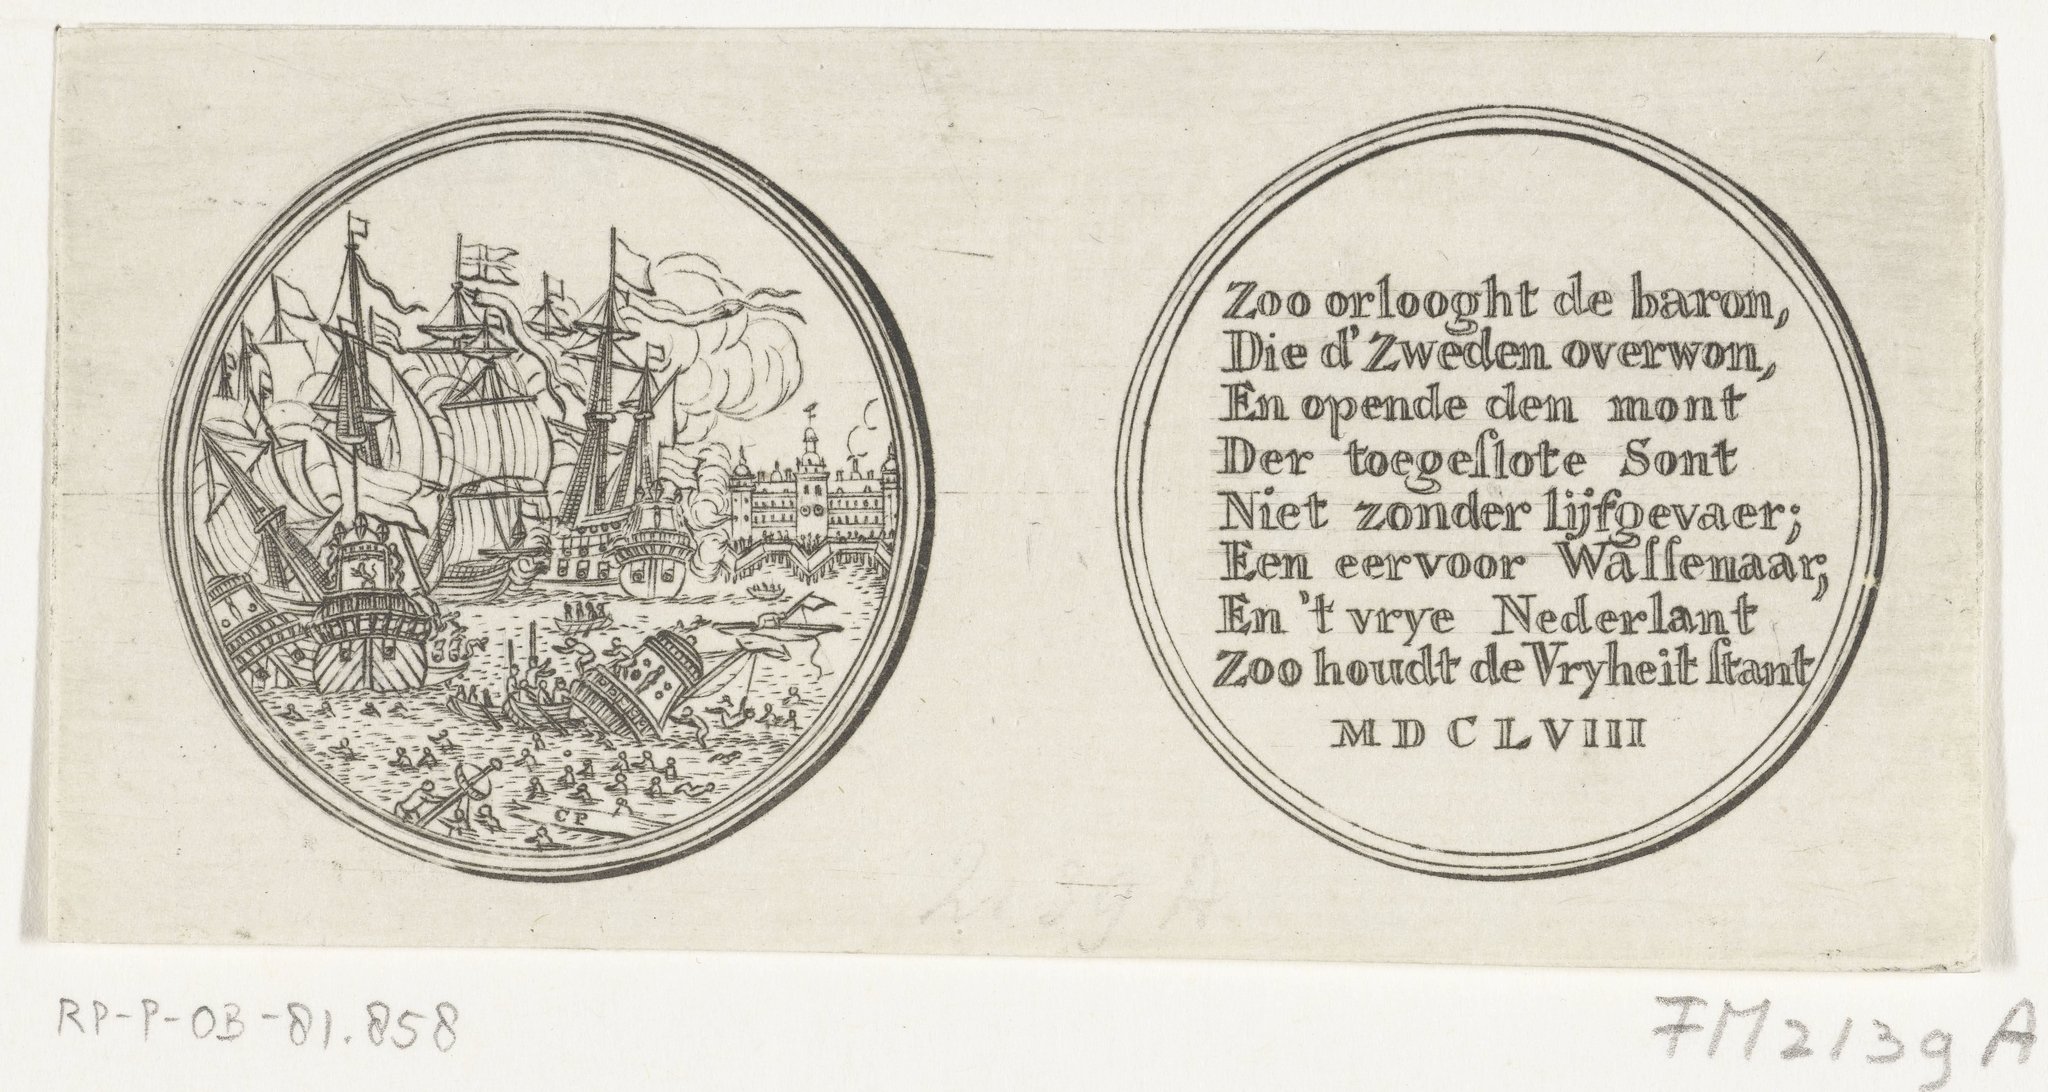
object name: historical object representation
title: Penning op de Slag in de Sont, 1658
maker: Anonymous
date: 1700-1749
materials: paper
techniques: etching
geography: northern netherlands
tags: jacob baron van wassenaer heer van obdam, battle (+ naval force), medal (considered as a piece of sculpture, regardless of its specific function)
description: Penning op de Slag in de Sont, tussen de Staatse vloot onder admiraal Jacob baron van Wassenaer, heer van Obdam, en de Zweedse vloot onder admiraal Carl Gustaf Wrangel, 8 november 1658. Voorzijde: zeeslag met op achtergrond slot Kronborg. Keerzijde: opschrift.